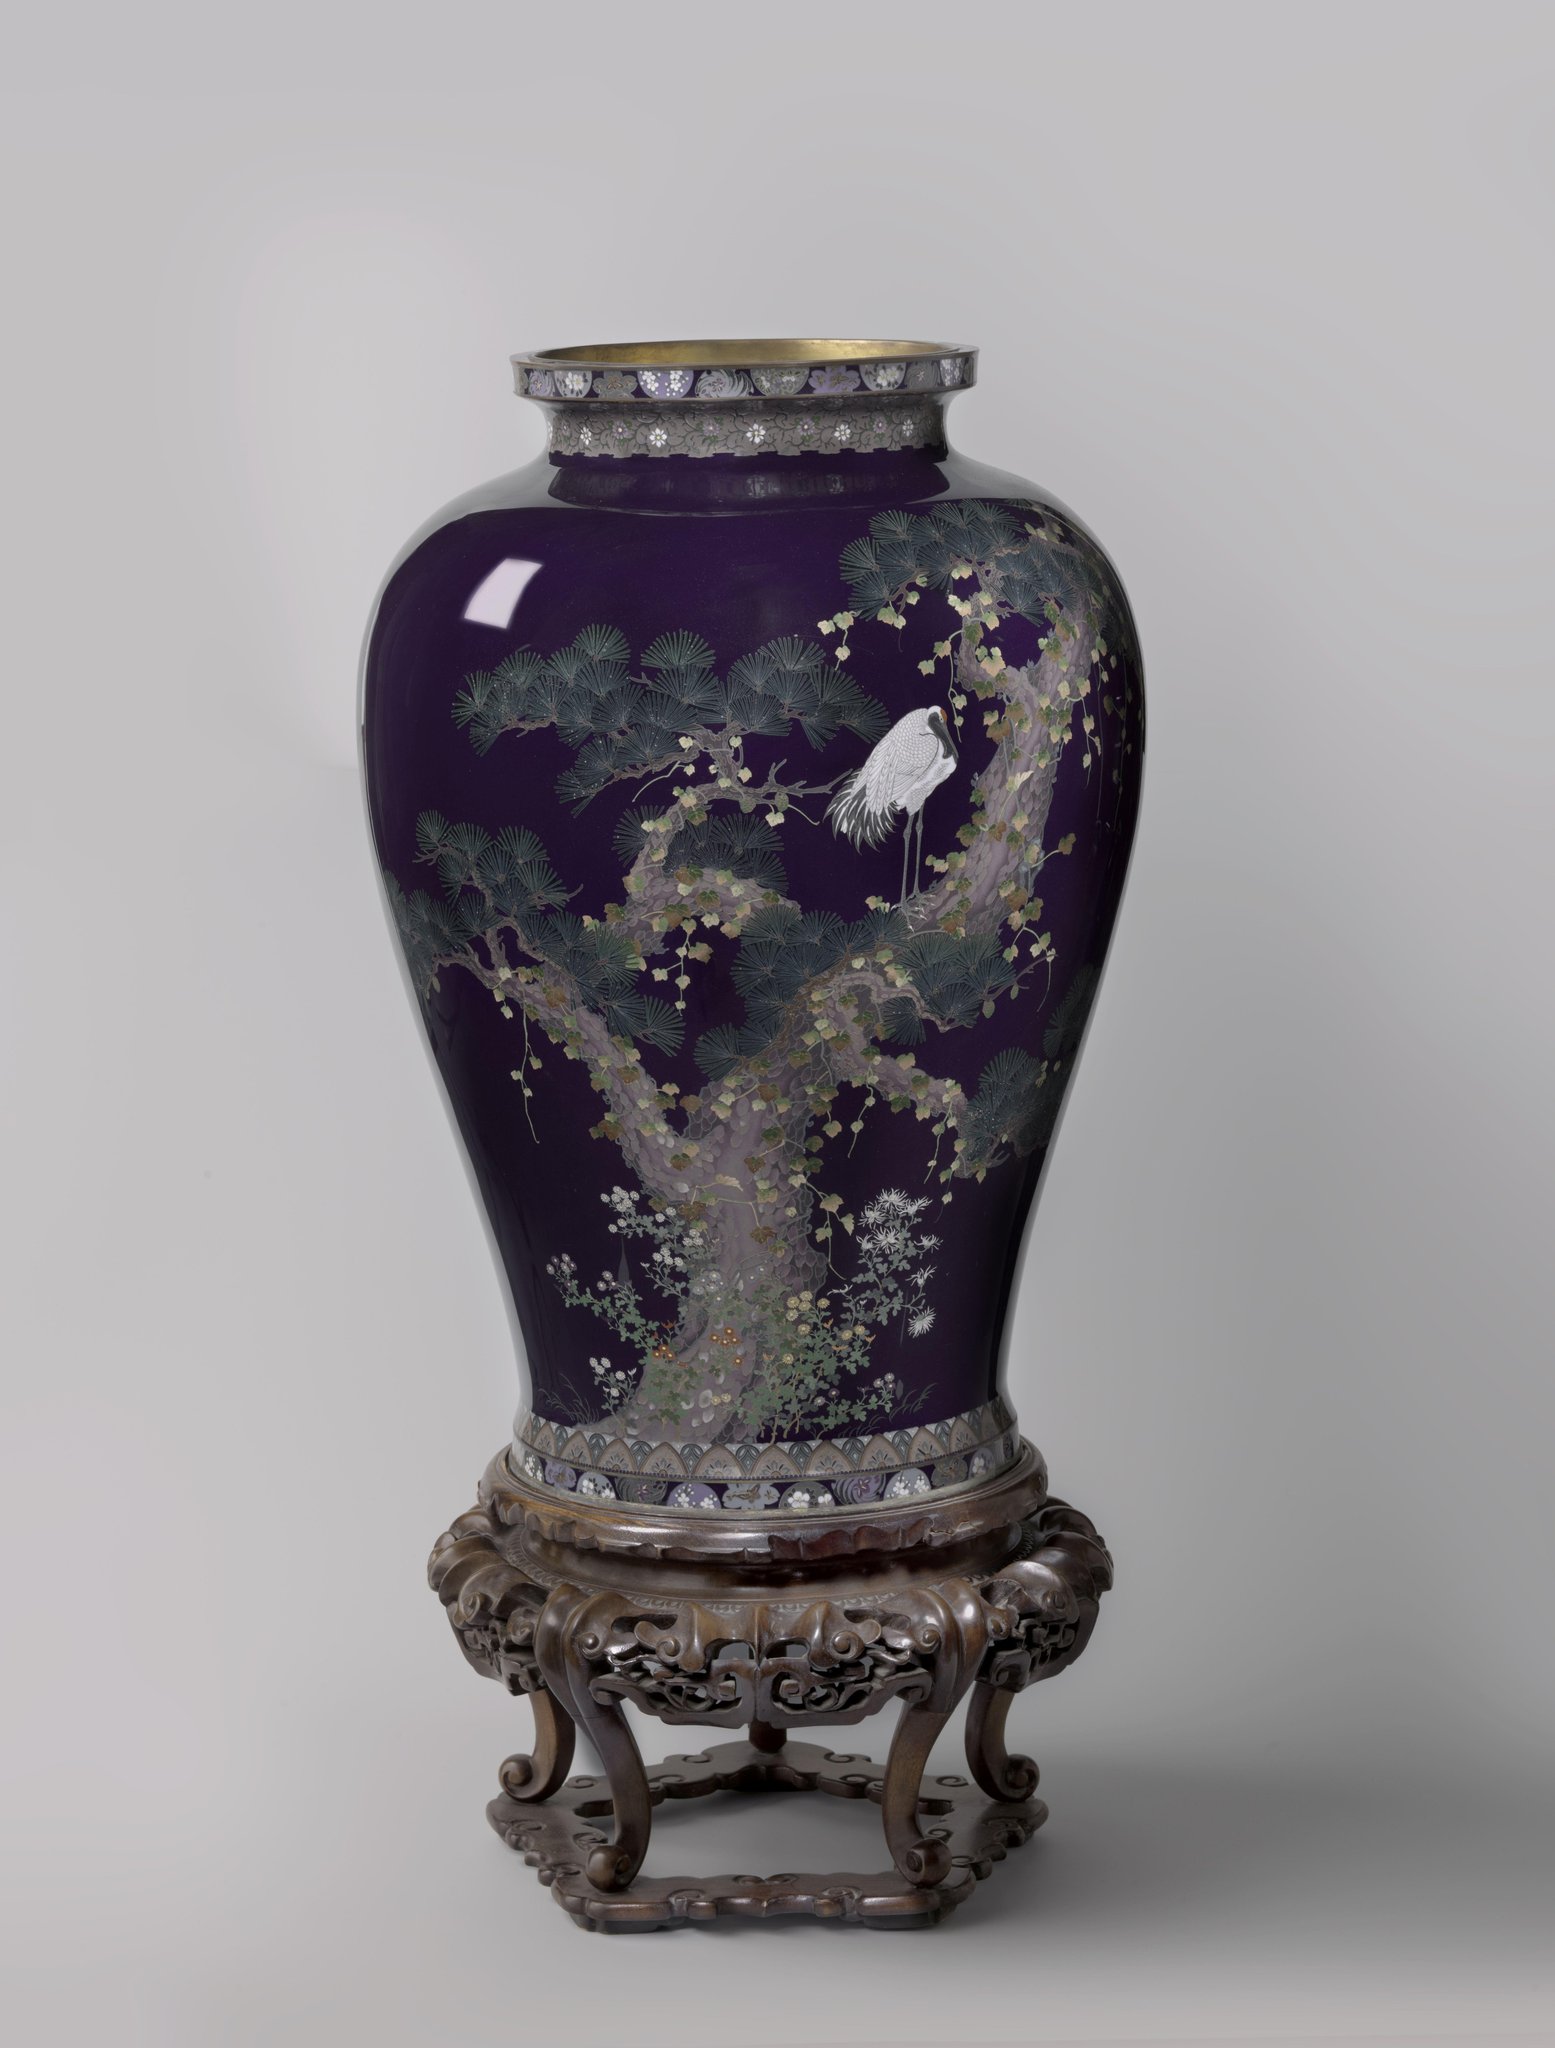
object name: vase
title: A pair of vases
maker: kôno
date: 1900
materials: copper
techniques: enamel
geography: yokohama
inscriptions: signature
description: These two vases are decorated with naturalistically represented cranes and pine trees on a deep-blue ground. Both pine trees and cranes symbolise long life. The detailed rendering and sophisticated colour nuances illustrate the technical progress undergone by the cloisonné enamel process since the opening of Japan in 1854. Like Tokyo and Nagoya, Yokohama was a centre for the export of cloisonné enamel wares.